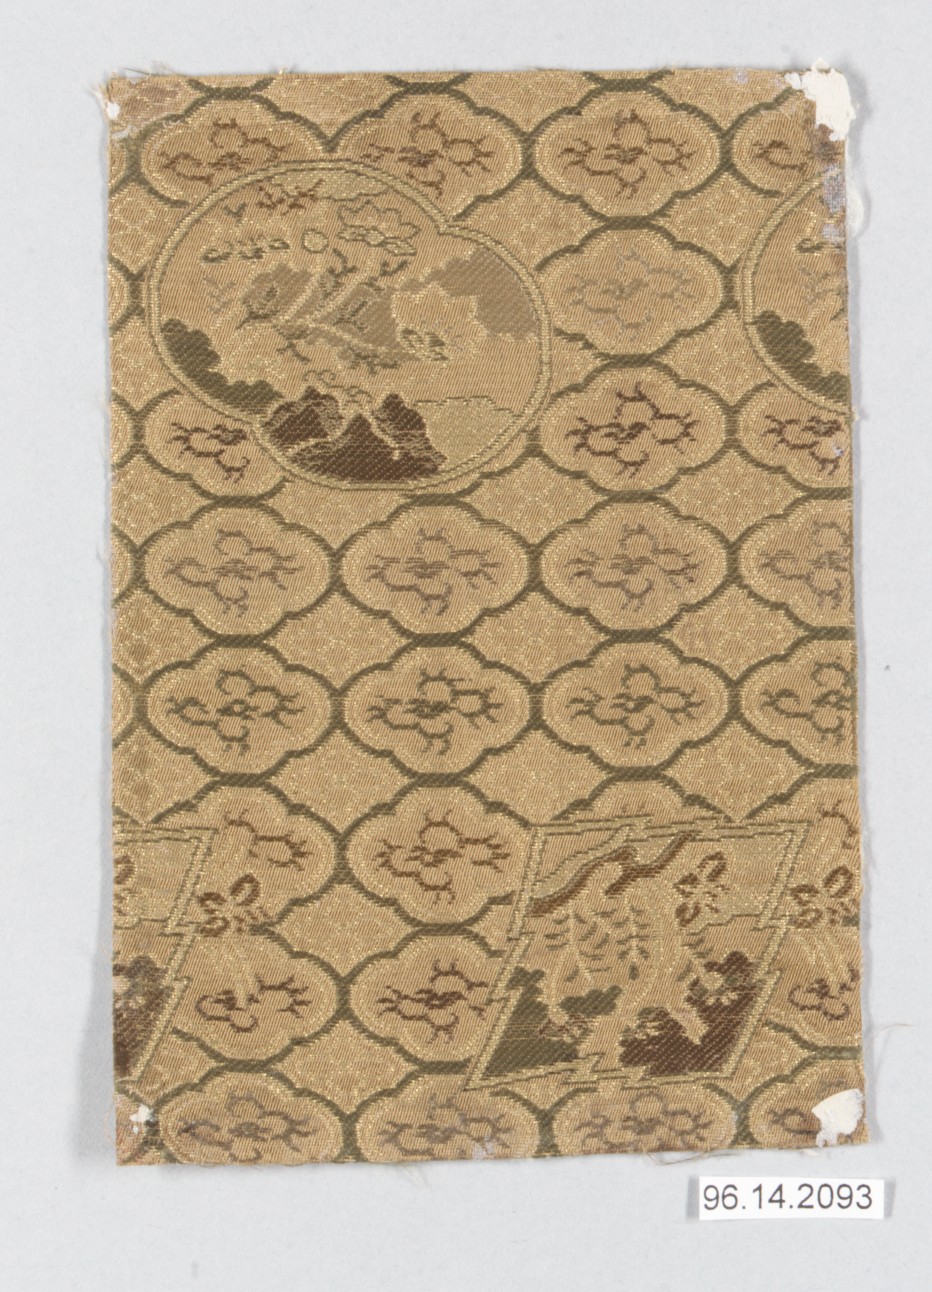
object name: piece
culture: japanese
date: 1701-1900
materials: silk